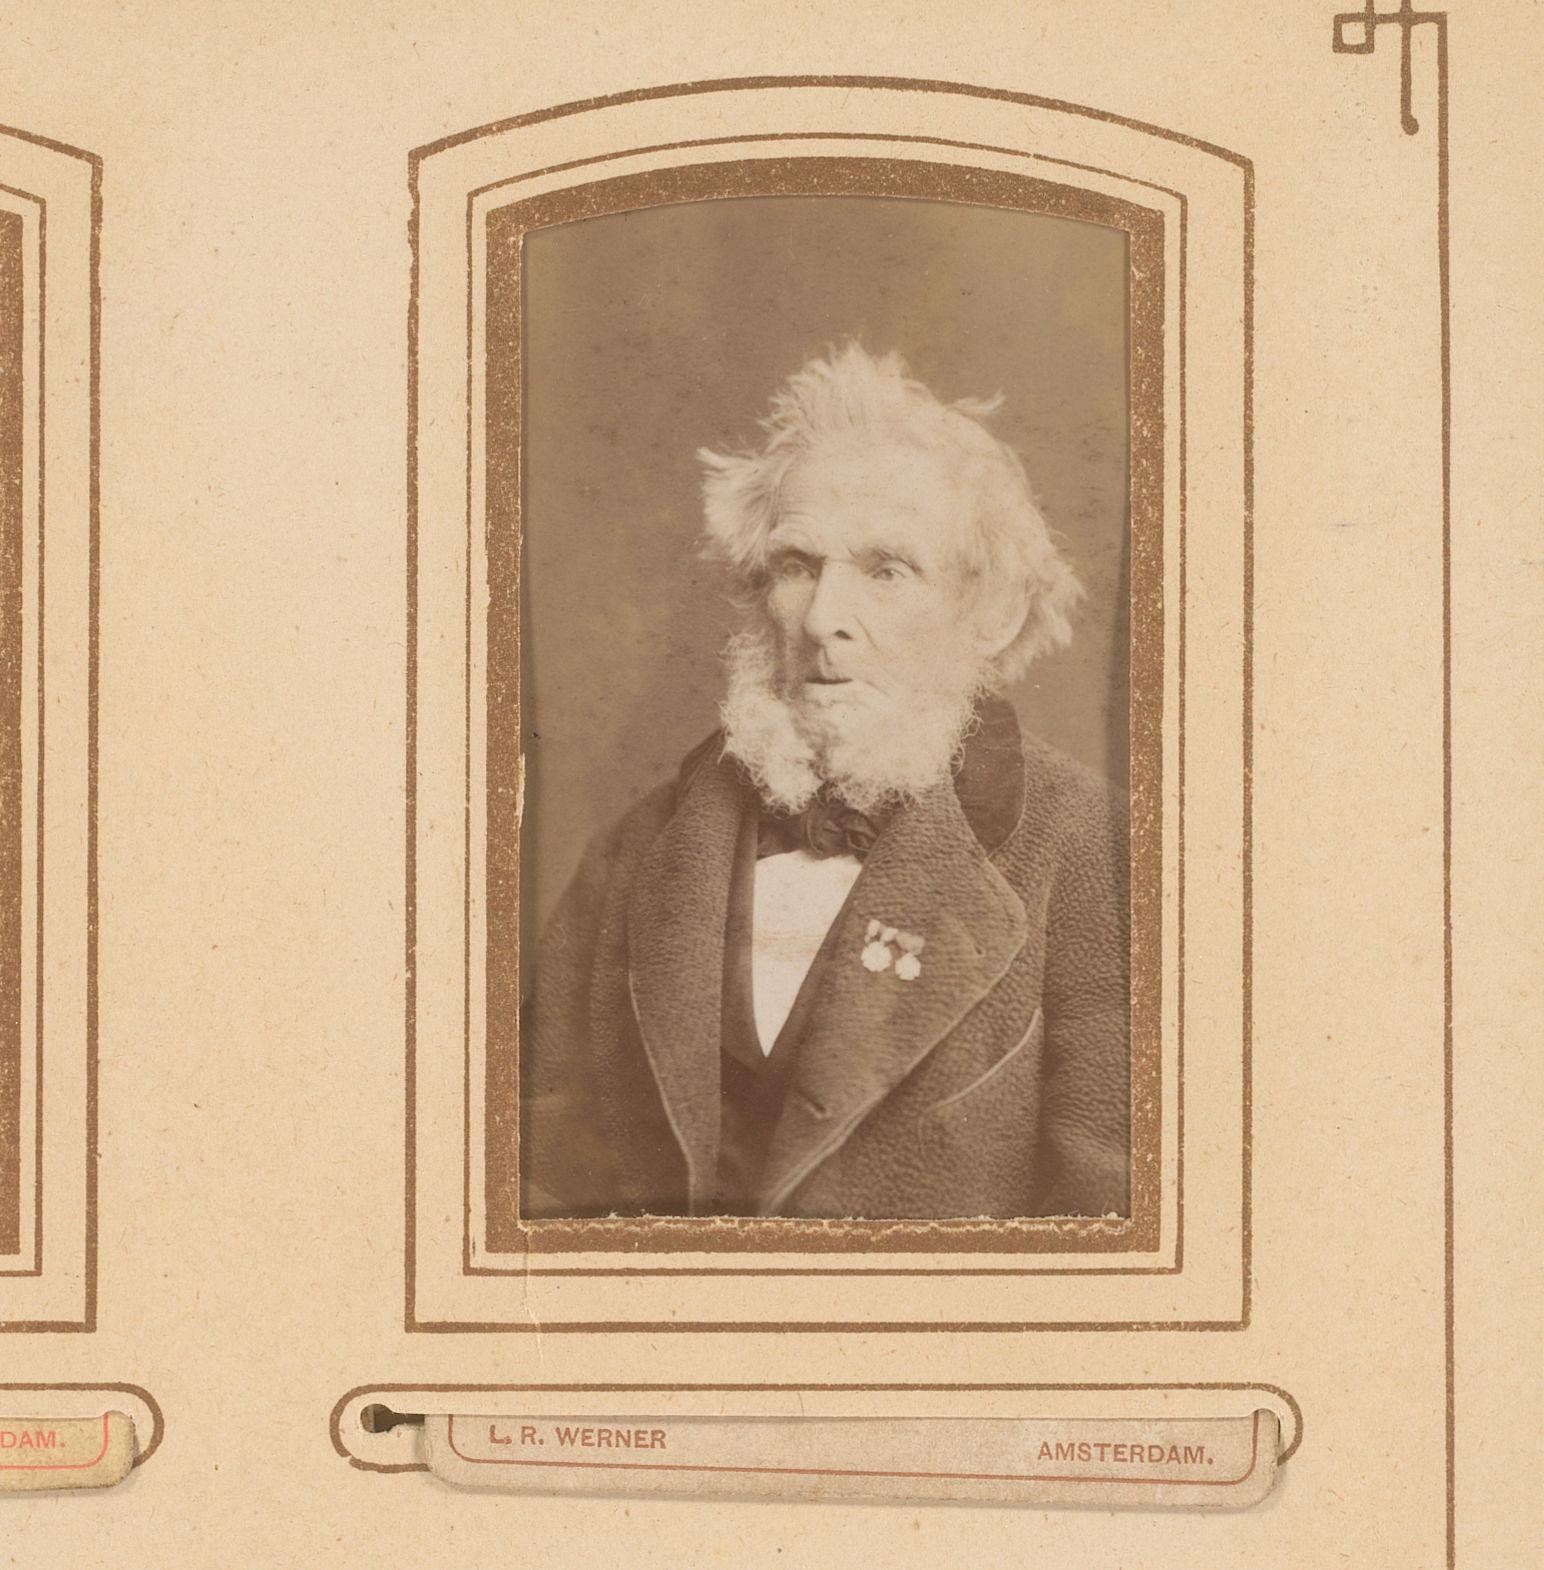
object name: album leaf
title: Portret van een man met baard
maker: louis robert werner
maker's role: fotograaf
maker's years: 1834-1896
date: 1878-1886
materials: cardboard, photographic support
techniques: albumen print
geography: amsterdam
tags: historical persons, beard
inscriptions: inscription: ‘L.R. Werner/ voorheen/ P. Carstensen/ Nieuwendyk H.150/ Amsterdam’, number: ‘83’